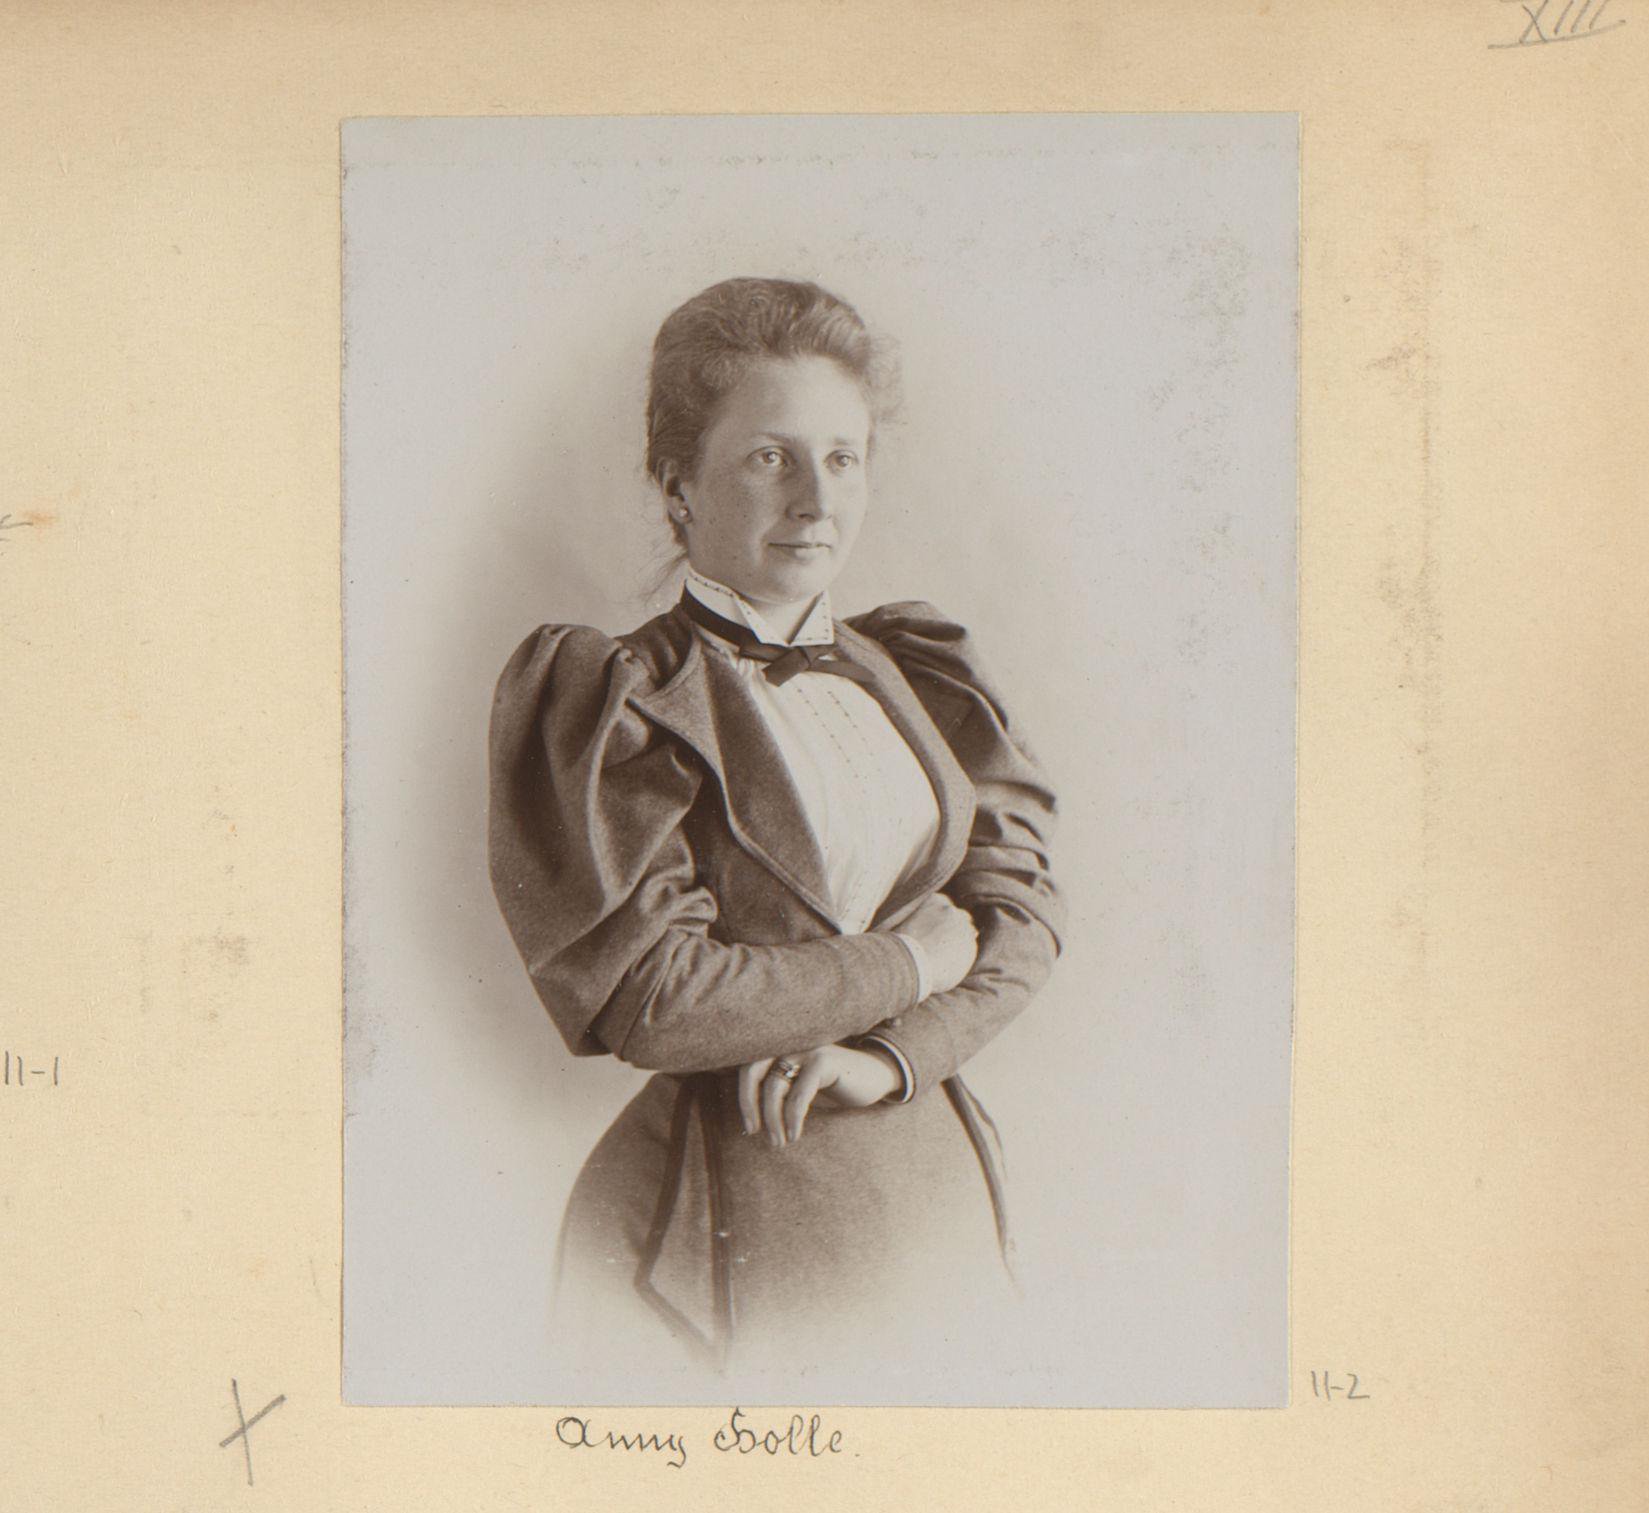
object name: album leaf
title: Fotoreproductie van een gefotografeerd portret van Annie Holle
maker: hendrik herman van den berg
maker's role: amateurfotograaf, jurist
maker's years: 1875-1944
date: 1890-1894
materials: paper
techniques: collodion silver print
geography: amsterdam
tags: batavia, historical persons - bb - woman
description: Foto 2 op albumblad 11 uit album "Amsterdam 1890-1894".